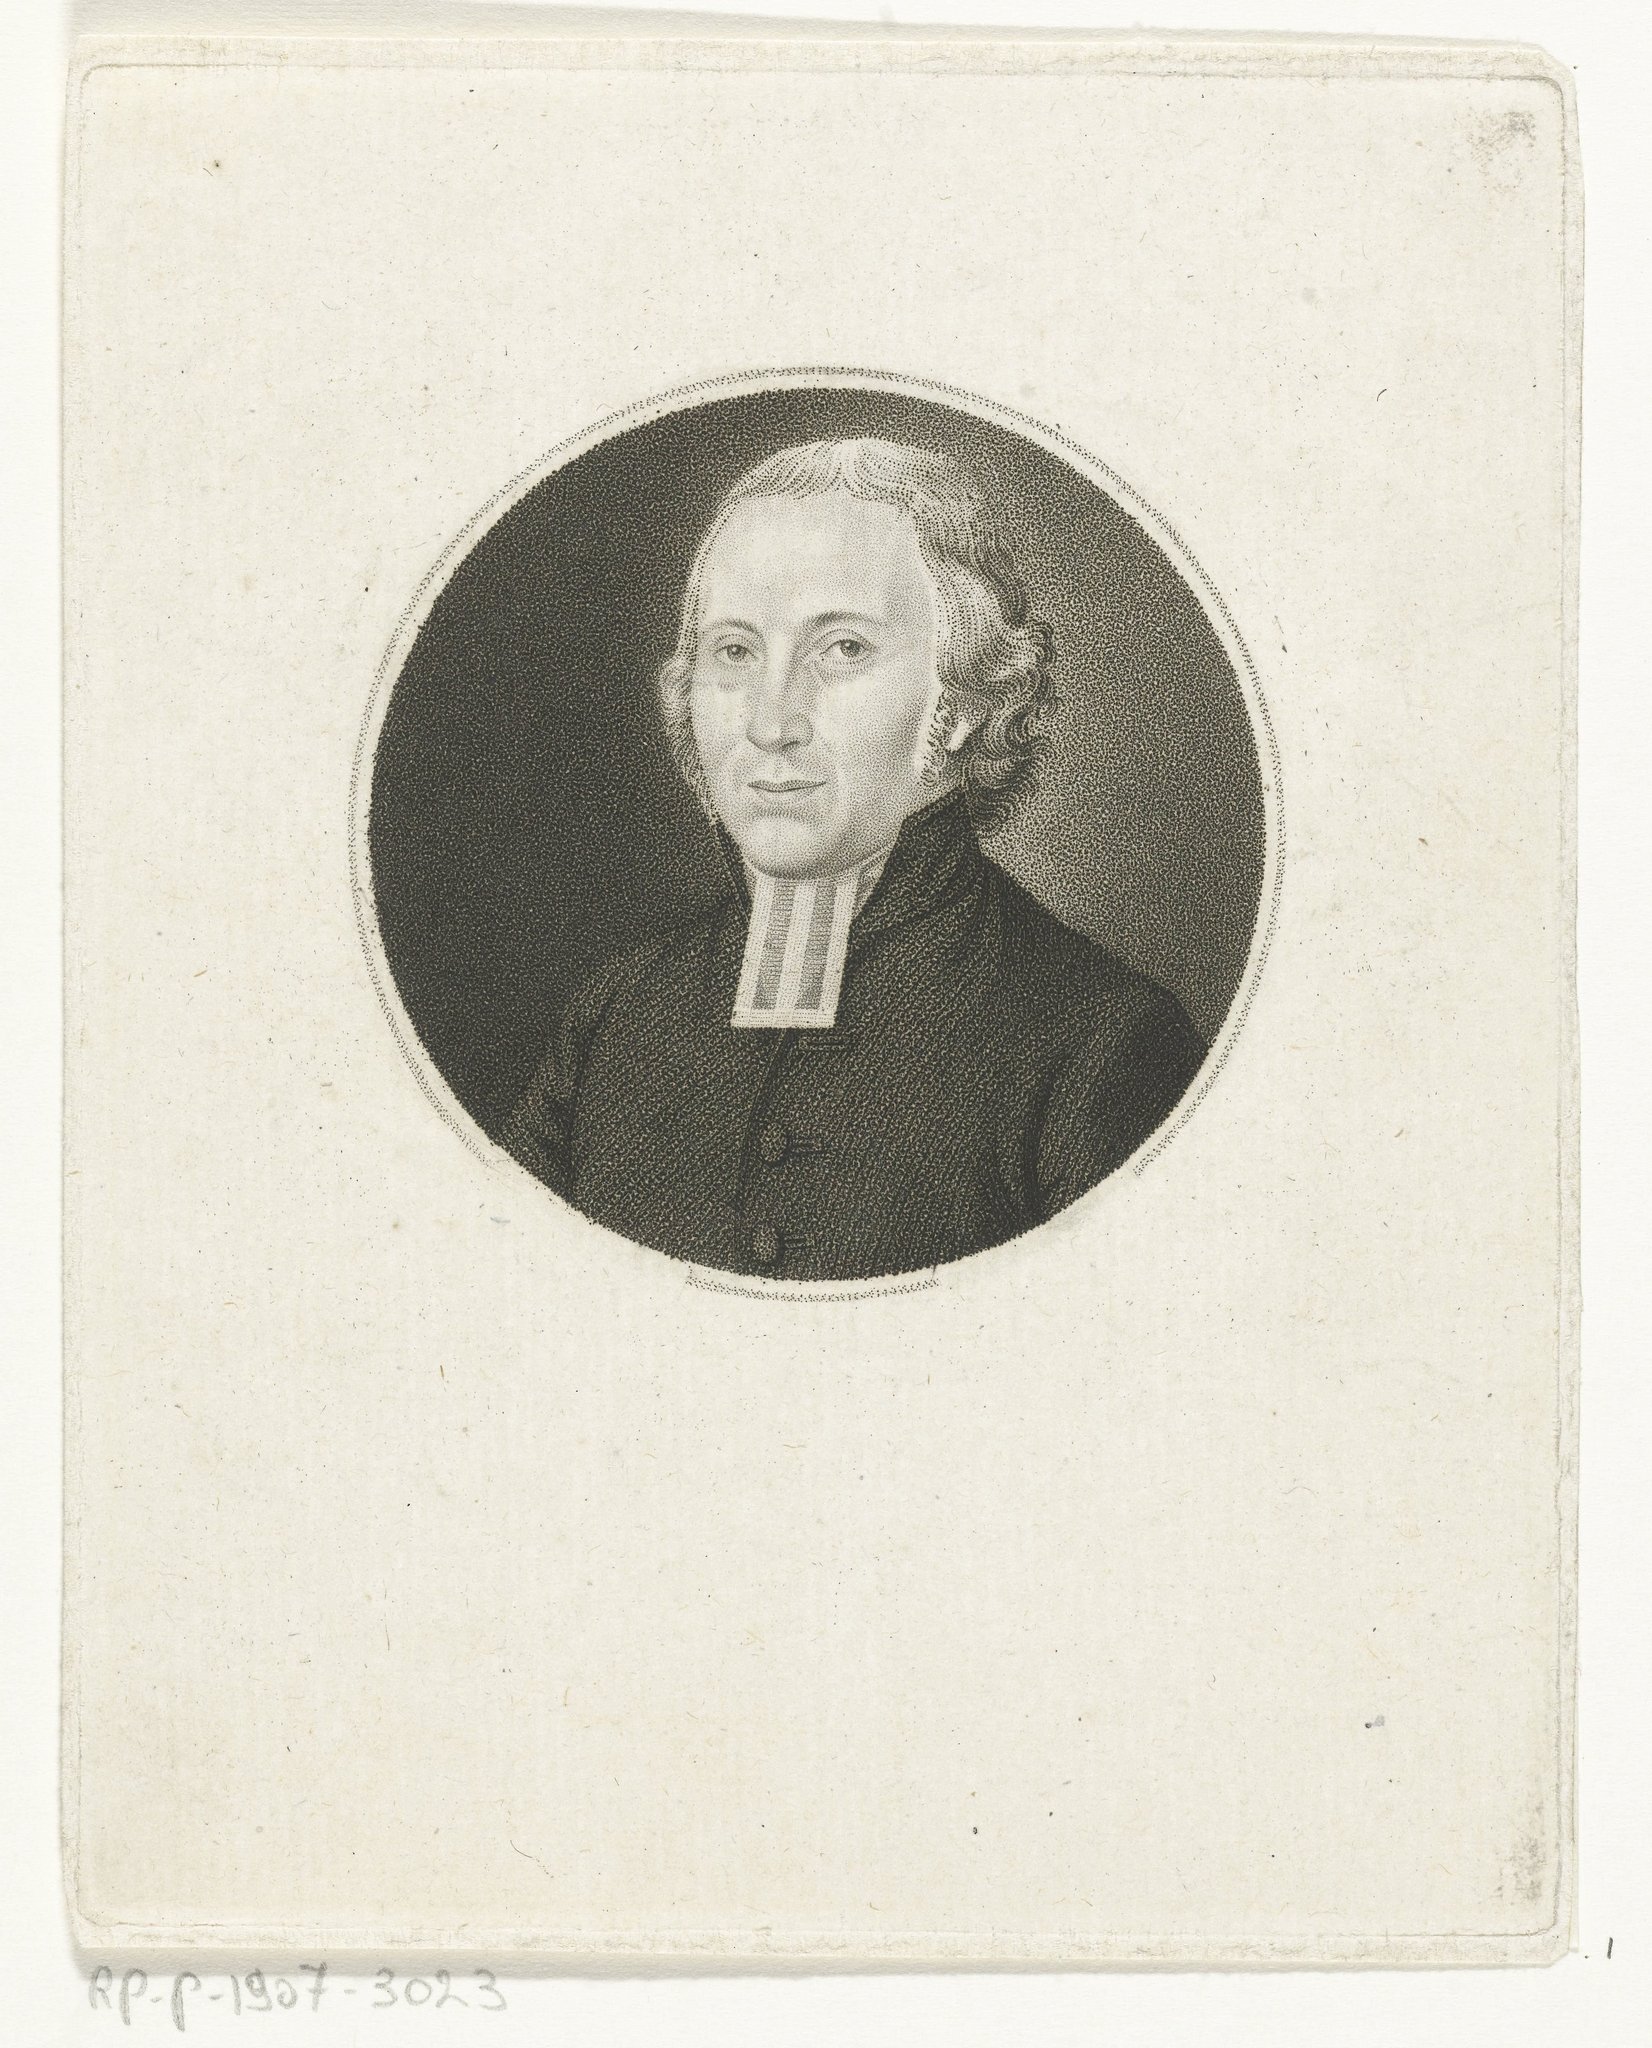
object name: print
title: Portret van Lodewijk Ten Bokkel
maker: jan willem caspari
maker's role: print maker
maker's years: 1779-1822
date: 1789-1822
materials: paper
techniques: etching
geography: amsterdam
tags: leeuwarden, predikant, lodewijk ten bokkel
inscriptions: collector's mark: Lugt 2166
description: Portret in ronde lijst van Lodewijk Ten Bokkel, Predikant van de Nederlandse hervormde gemeente te Monnickendam. Buste naar links. Ten Bokkel heeft een zwarte jas aan met een witte bef.